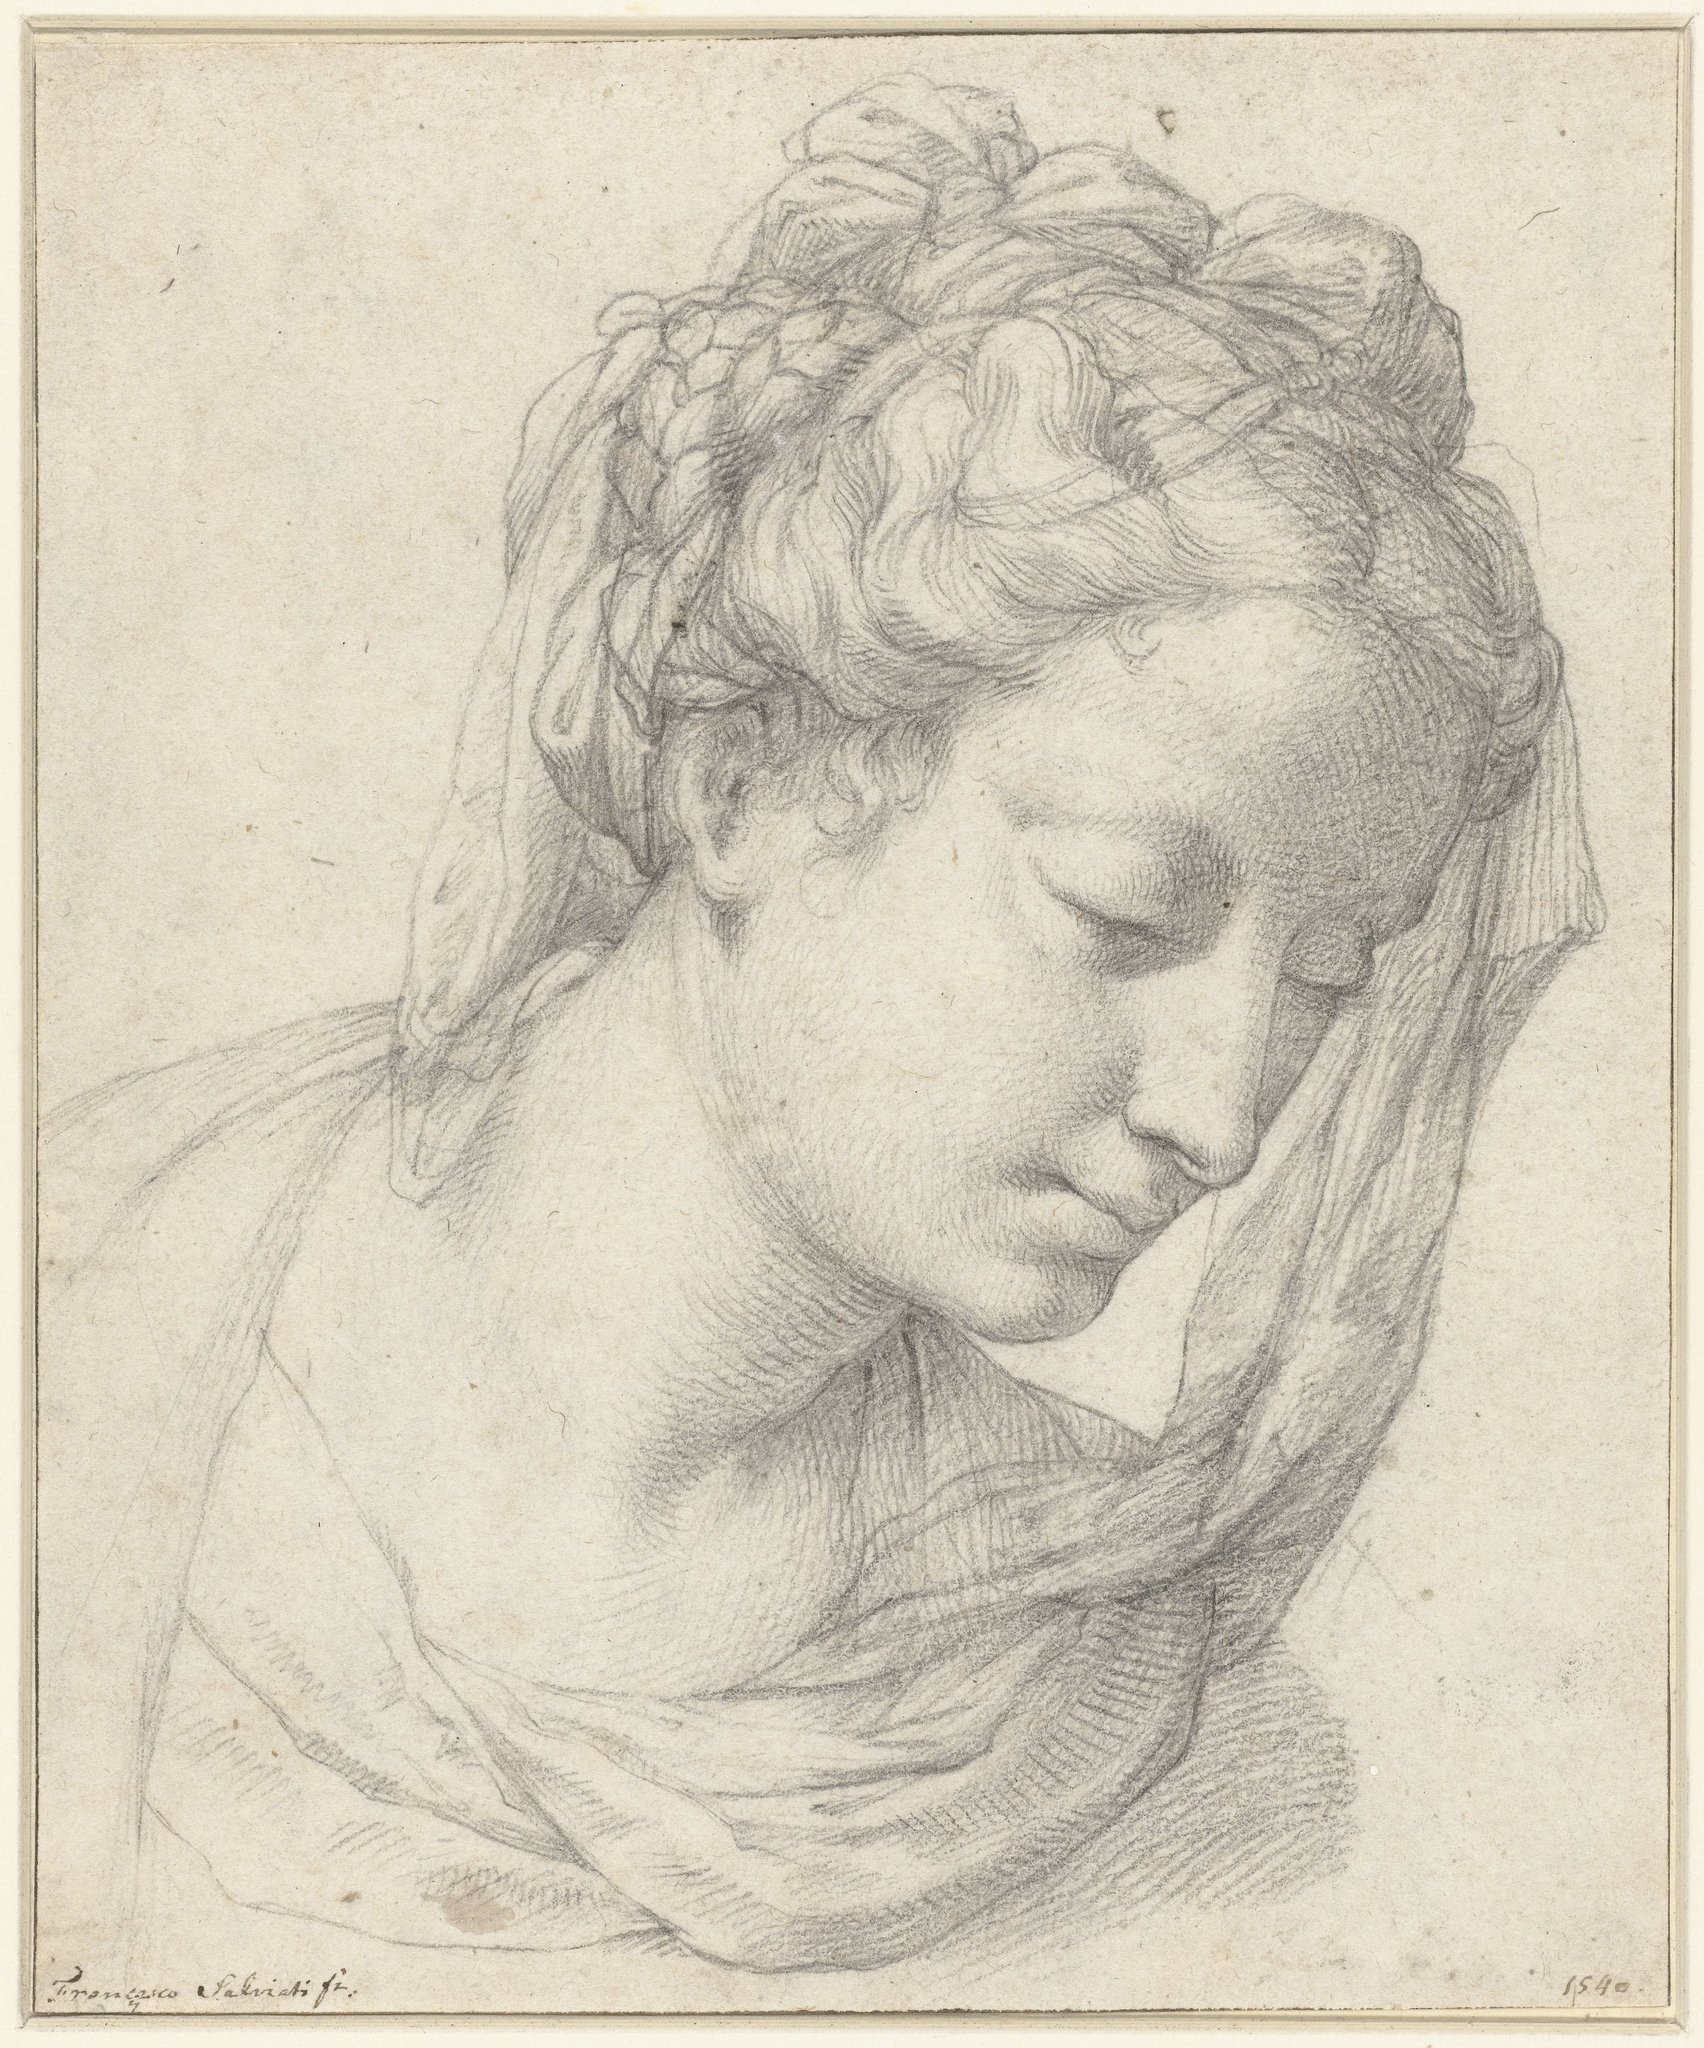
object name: drawing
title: Hoofd van een vrouw, driekwart naar rechts en naar beneden kijkend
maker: francesco salviati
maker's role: draughtsman, painter, print maker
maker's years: 1510-1563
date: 1520-1563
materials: chalk, paper